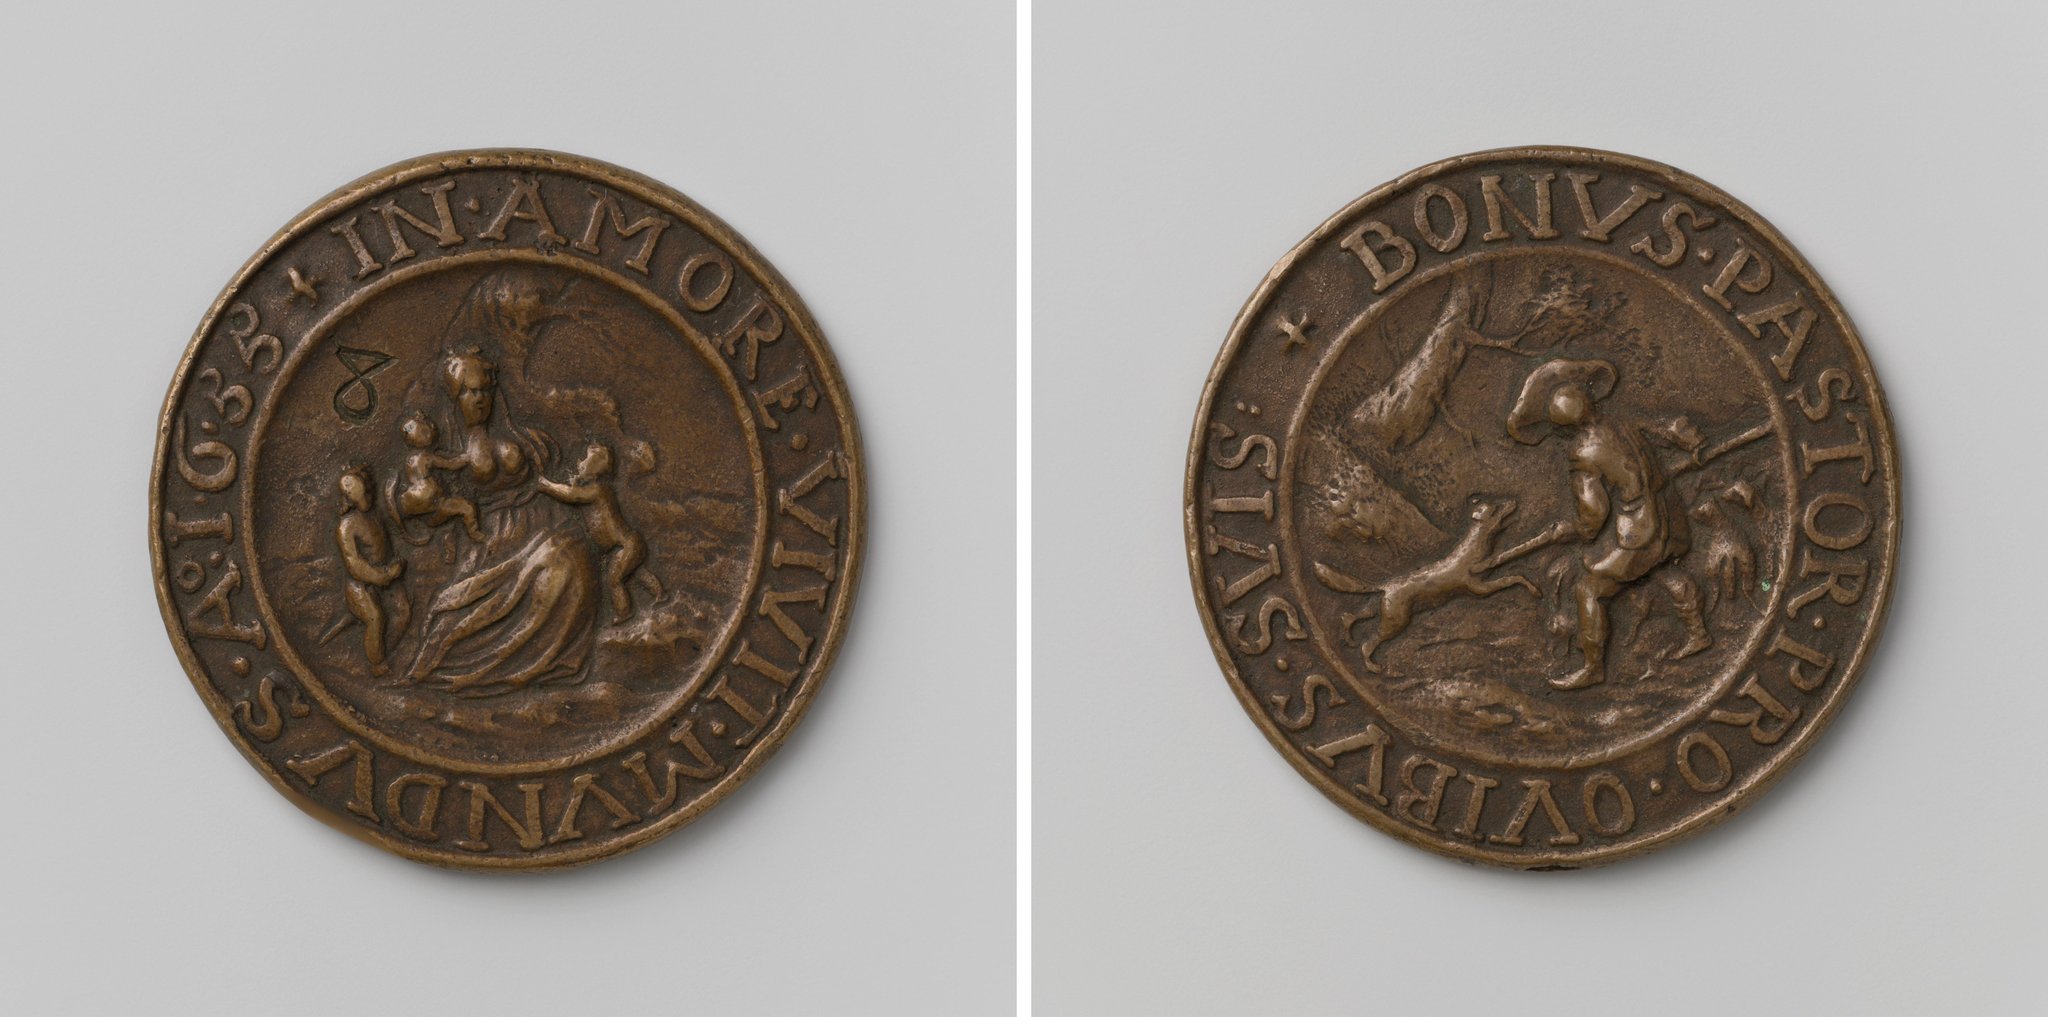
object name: buurtpenning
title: Onbekende buurt te 's-Gravenhage, buurtpenning met no. 8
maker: Anonymous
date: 1655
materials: brass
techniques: casting, engraving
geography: the hague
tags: the hague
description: Messing penning. Voorzijde: zittende vrouw met drie kinderen; links boven: cijfer 8 binnen omschrift. Keerzijde: herder met hoed op hoofd houdt met stok wolf van zijn kudde vandaan binnen omschrift